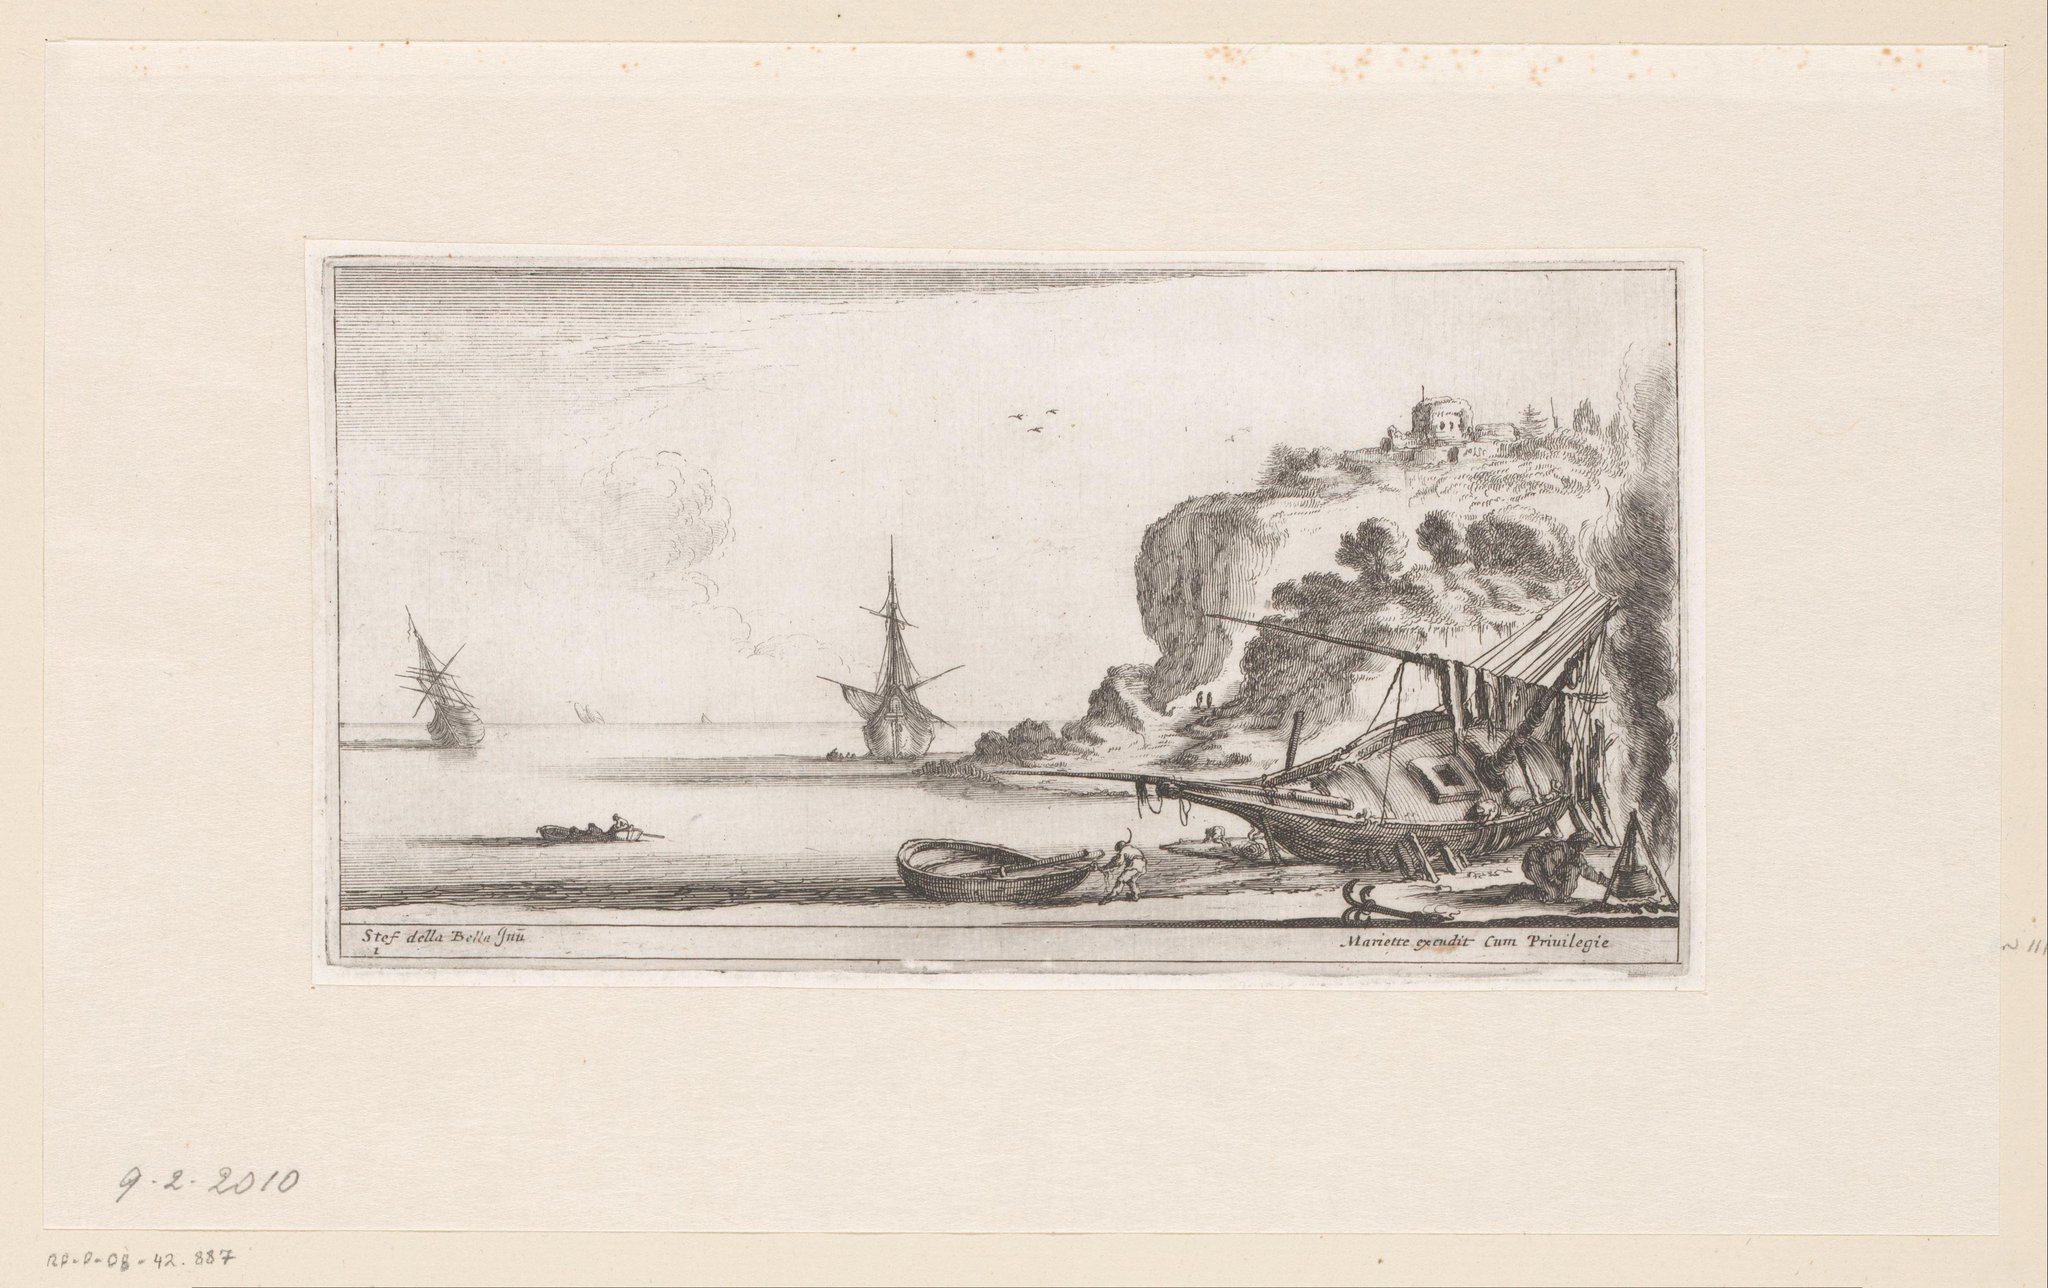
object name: print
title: Vier landschappen waaronder zeezichten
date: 1643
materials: paper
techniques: engraving, etching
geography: france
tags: sailing-ship, sailing-boat, kitchen-fire - cc - in the open air, rowing-boat, canoe, etc., coast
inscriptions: collector's mark: Lugt 240, watermark